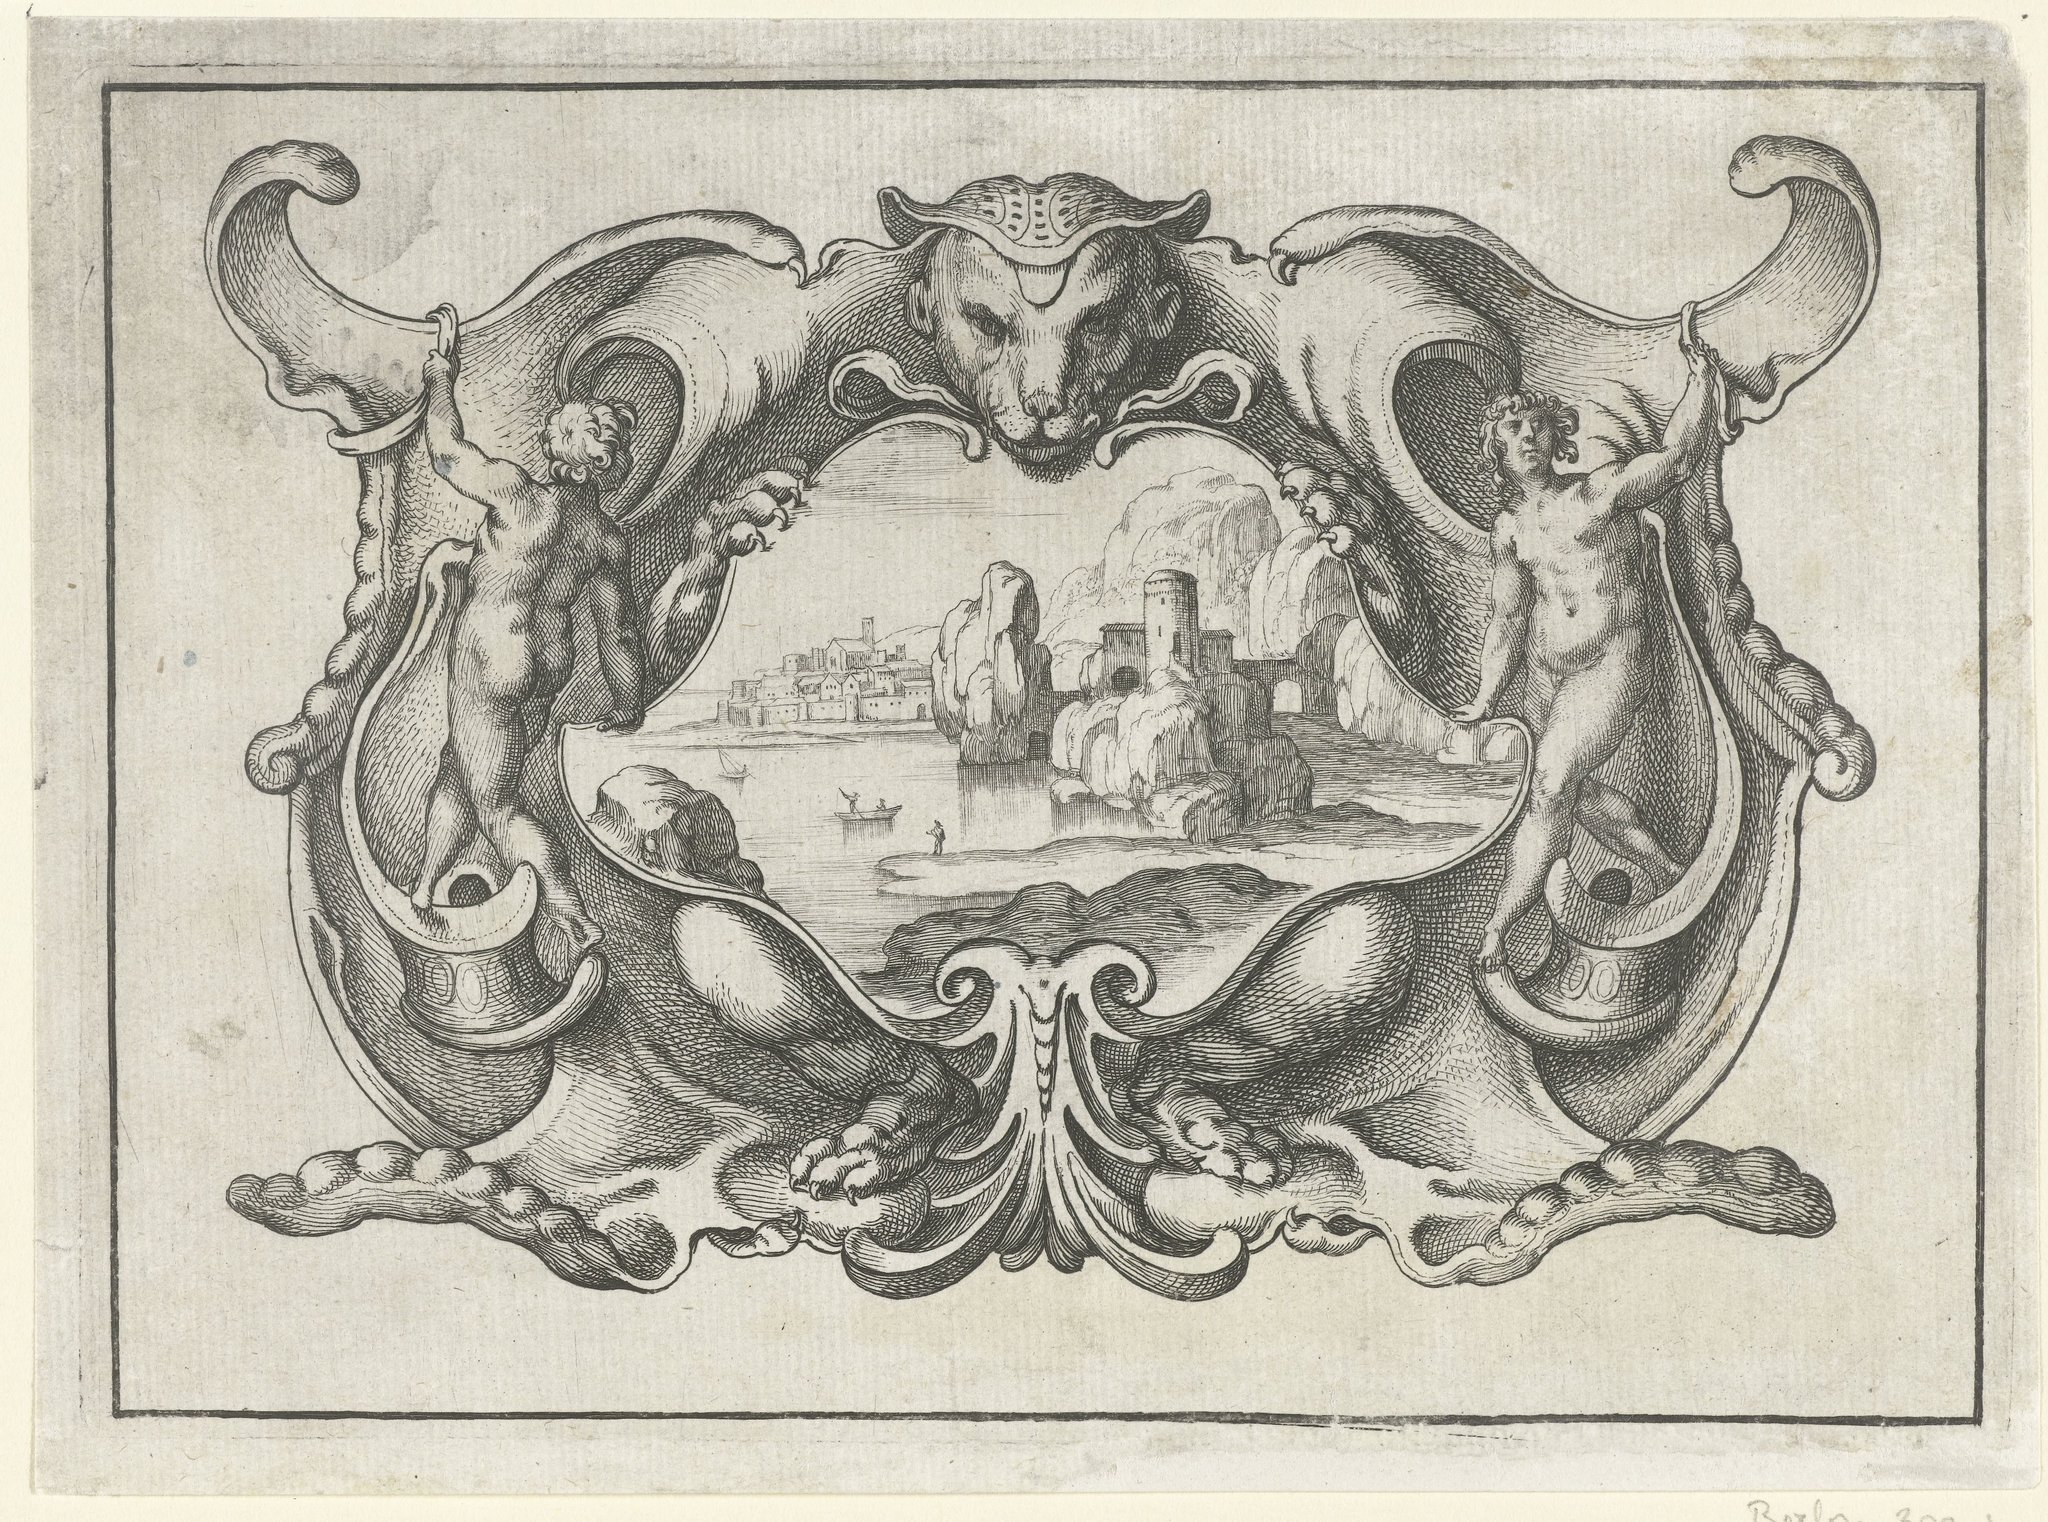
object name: ornament print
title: Cartouches de Differantes Inventions (...)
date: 1634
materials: paper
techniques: engraving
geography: paris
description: In het compartiment staat een kustlandschap afgebeeld. Blad 8 uit serie van 13 bladen met cartouches in Franse kwabstijl. Uit eerste editie.